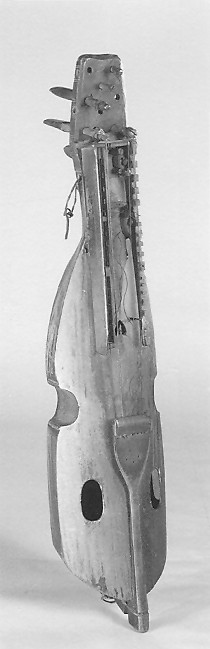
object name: nyckelharpa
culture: swedish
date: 1767-1800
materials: wood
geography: sweden